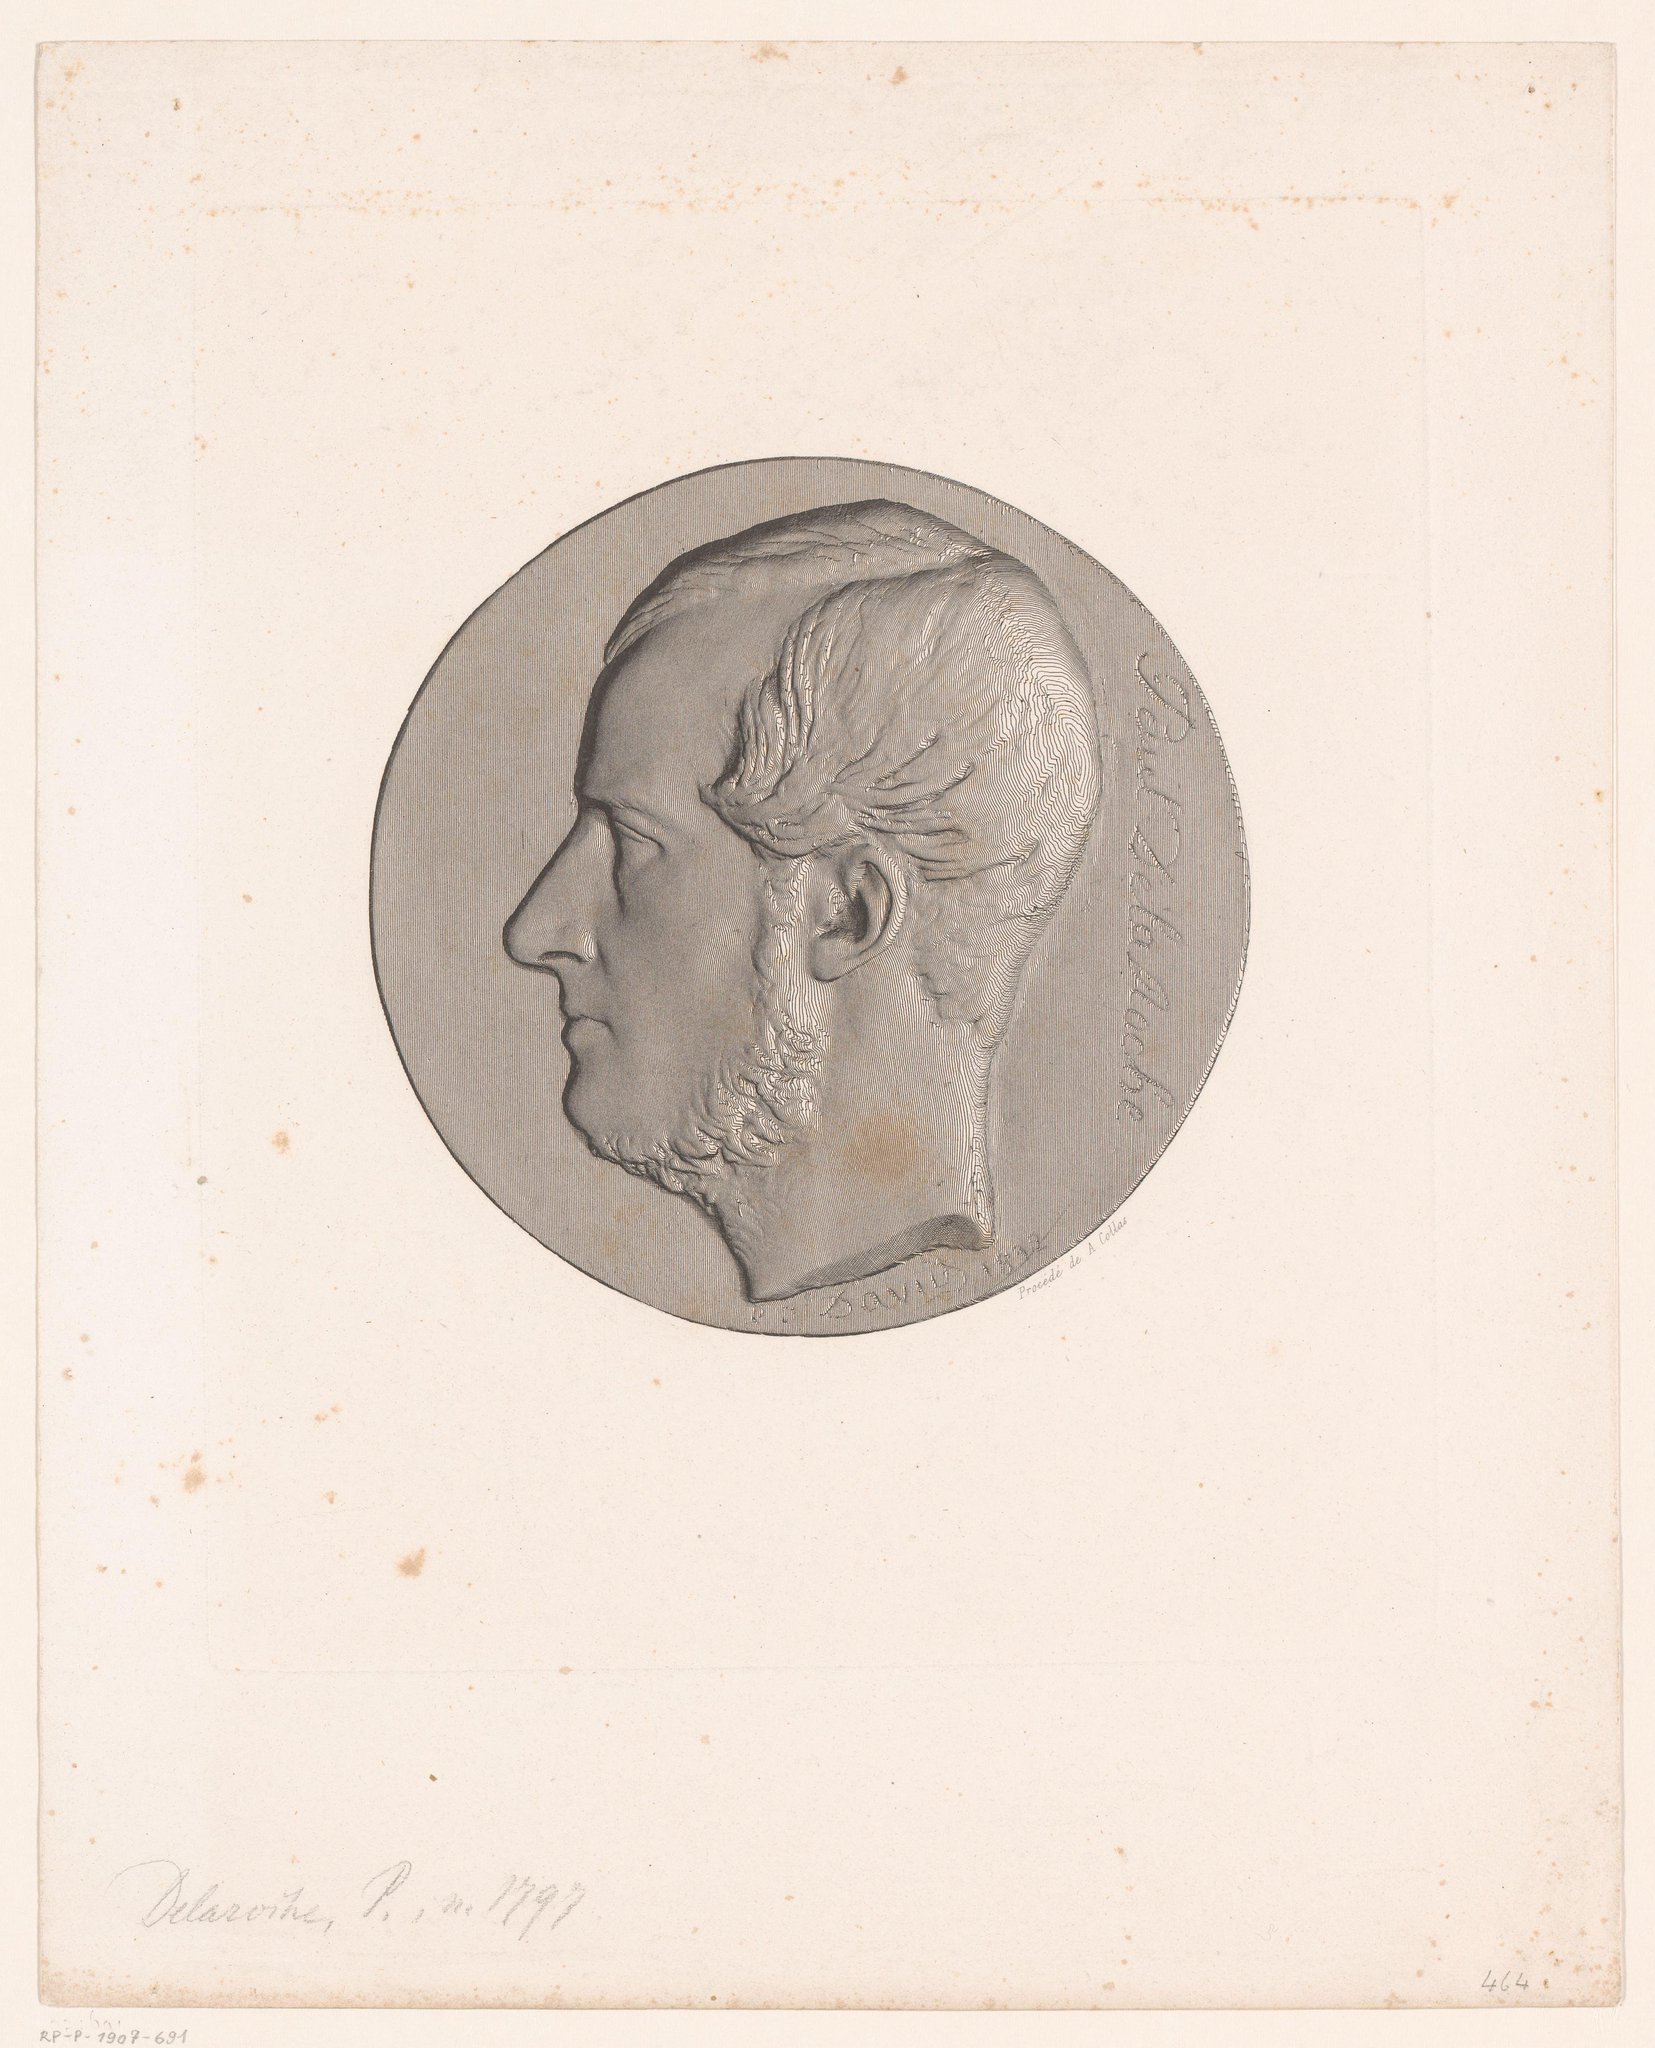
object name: print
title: Medaillon met portret van Paul Delaroche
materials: paper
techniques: relief engraving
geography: france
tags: paris, painter, draughtsman, paul delaroche, ornament ~ medallion, historical persons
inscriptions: collector's mark: Lugt 2228